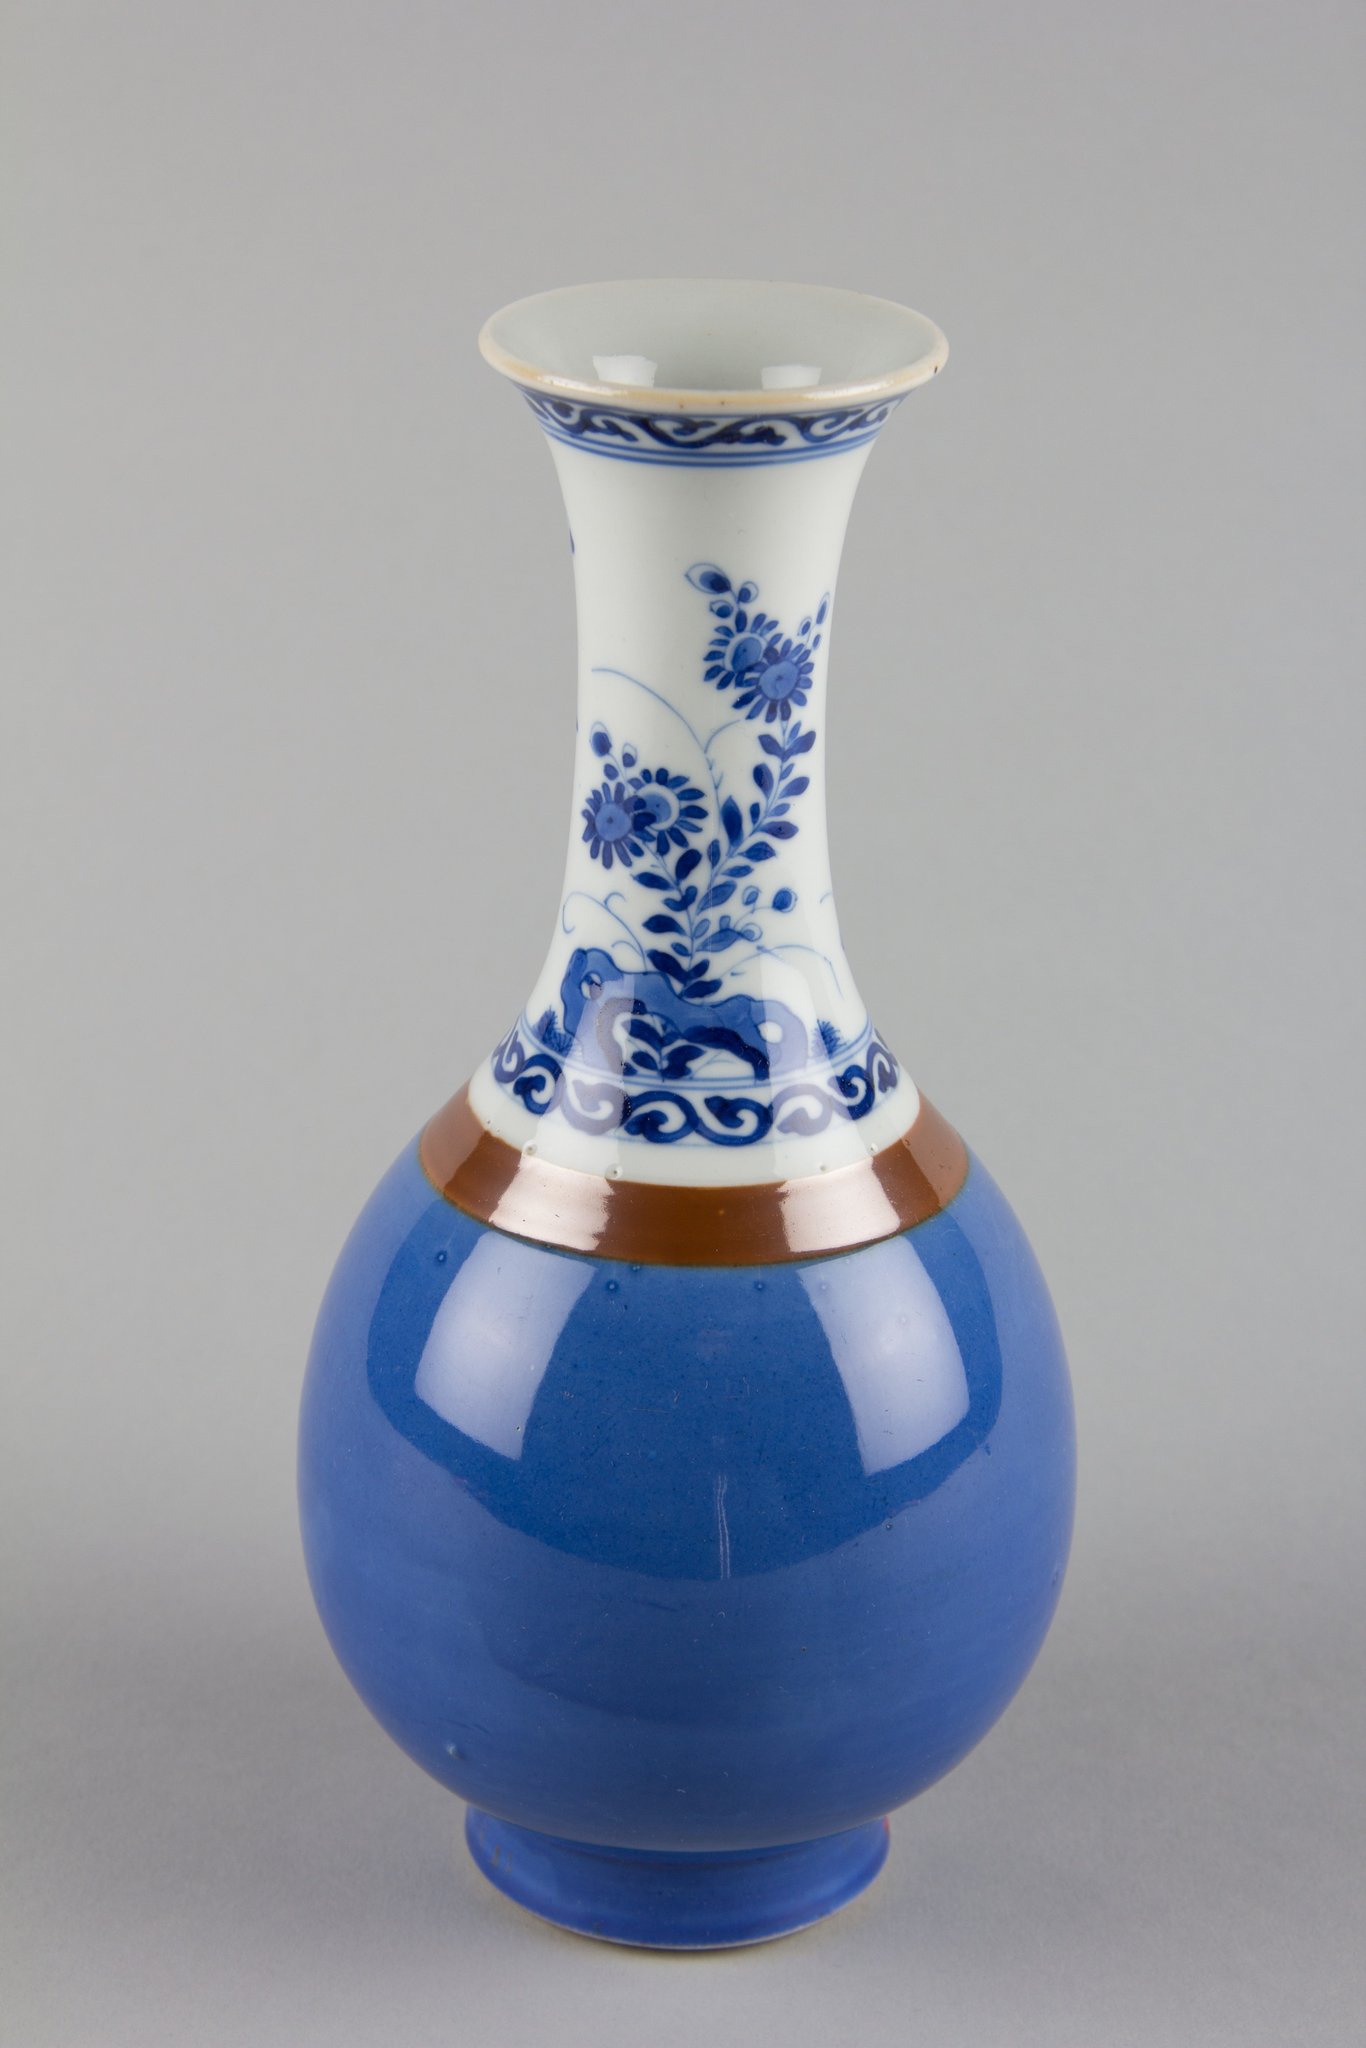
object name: vase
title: Vase with flowers and rocks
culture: chinese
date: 1667-1733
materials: cobalt, glaze, porcelain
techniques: painting, underglaze